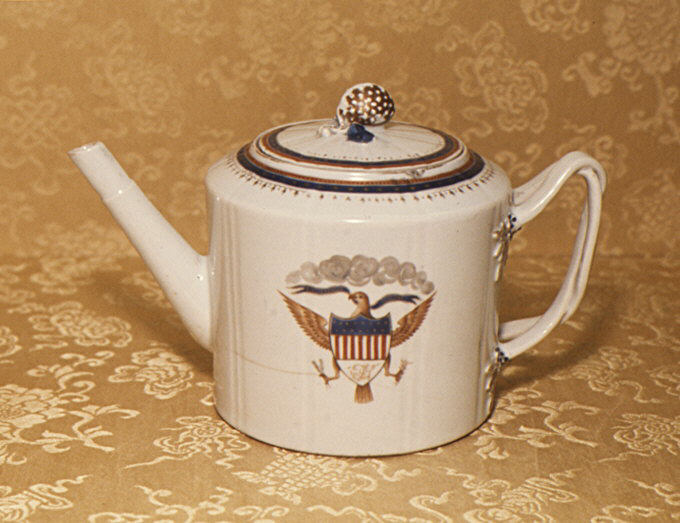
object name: teapot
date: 1795-1800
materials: hard paste porcelain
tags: eagles,coat of arms